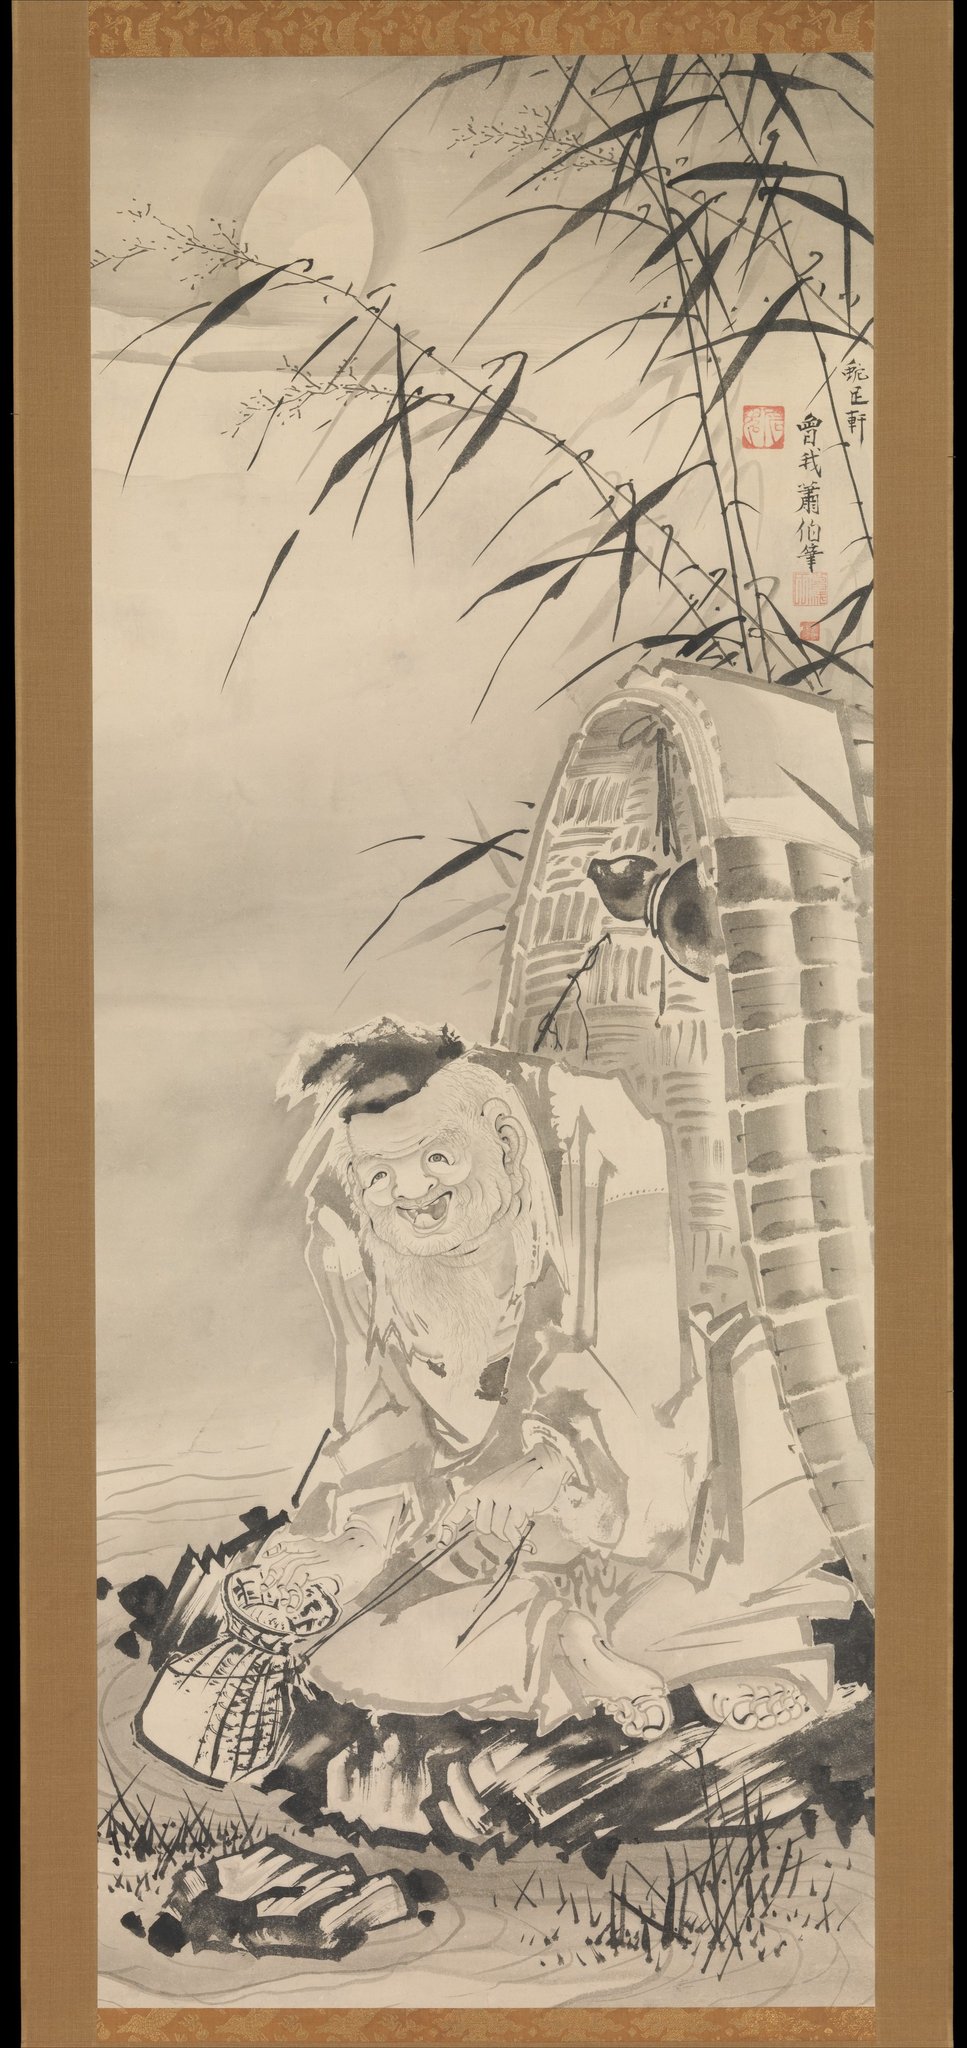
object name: hanging scroll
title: Tōkaibō with a Fishing Basket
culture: japanese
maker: soga shōhaku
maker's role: artist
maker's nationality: japanese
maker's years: 1730-1781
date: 1768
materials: ink, paper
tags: men